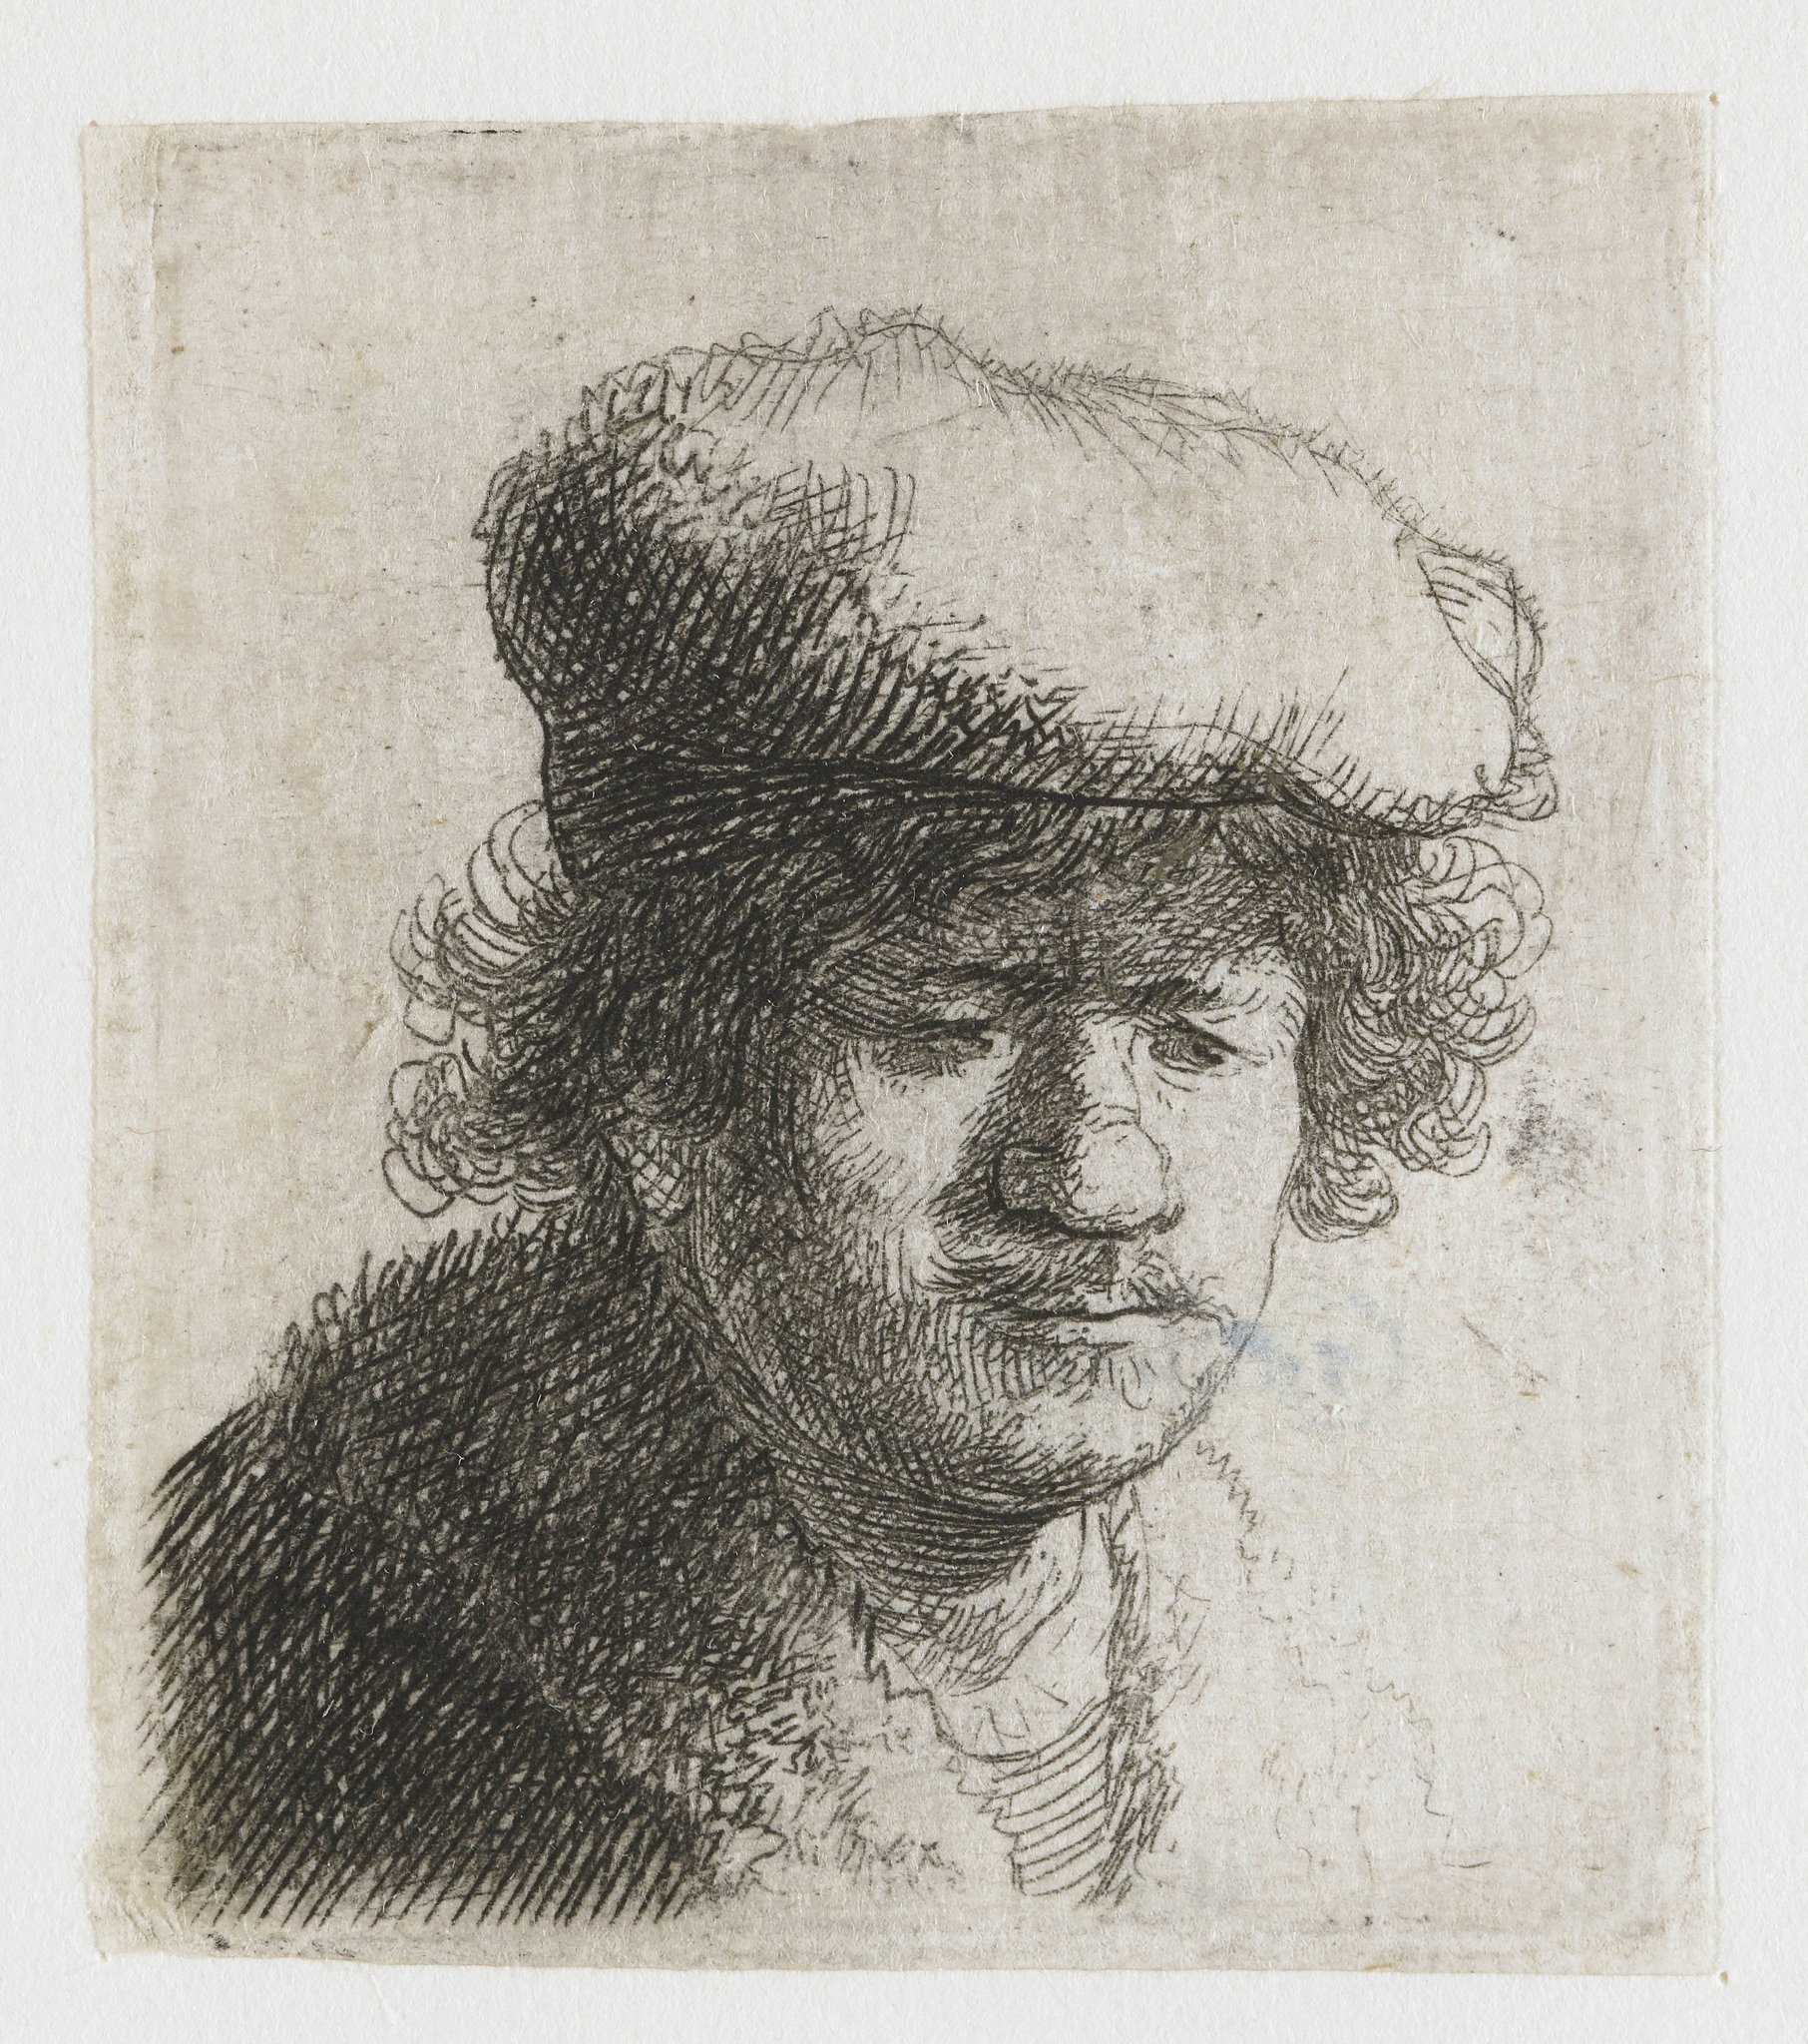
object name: print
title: Self-portrait with cap pulled forward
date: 1630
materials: paper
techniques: etching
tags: leiden, amsterdam, painter, print maker, draughtsman, rembrandt van rijn, head-gear: cap (+ men's clothes)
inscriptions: mark: Lugt 2228, mark: Lugt 923, inscription: ‘M 1169 (of 469?)’